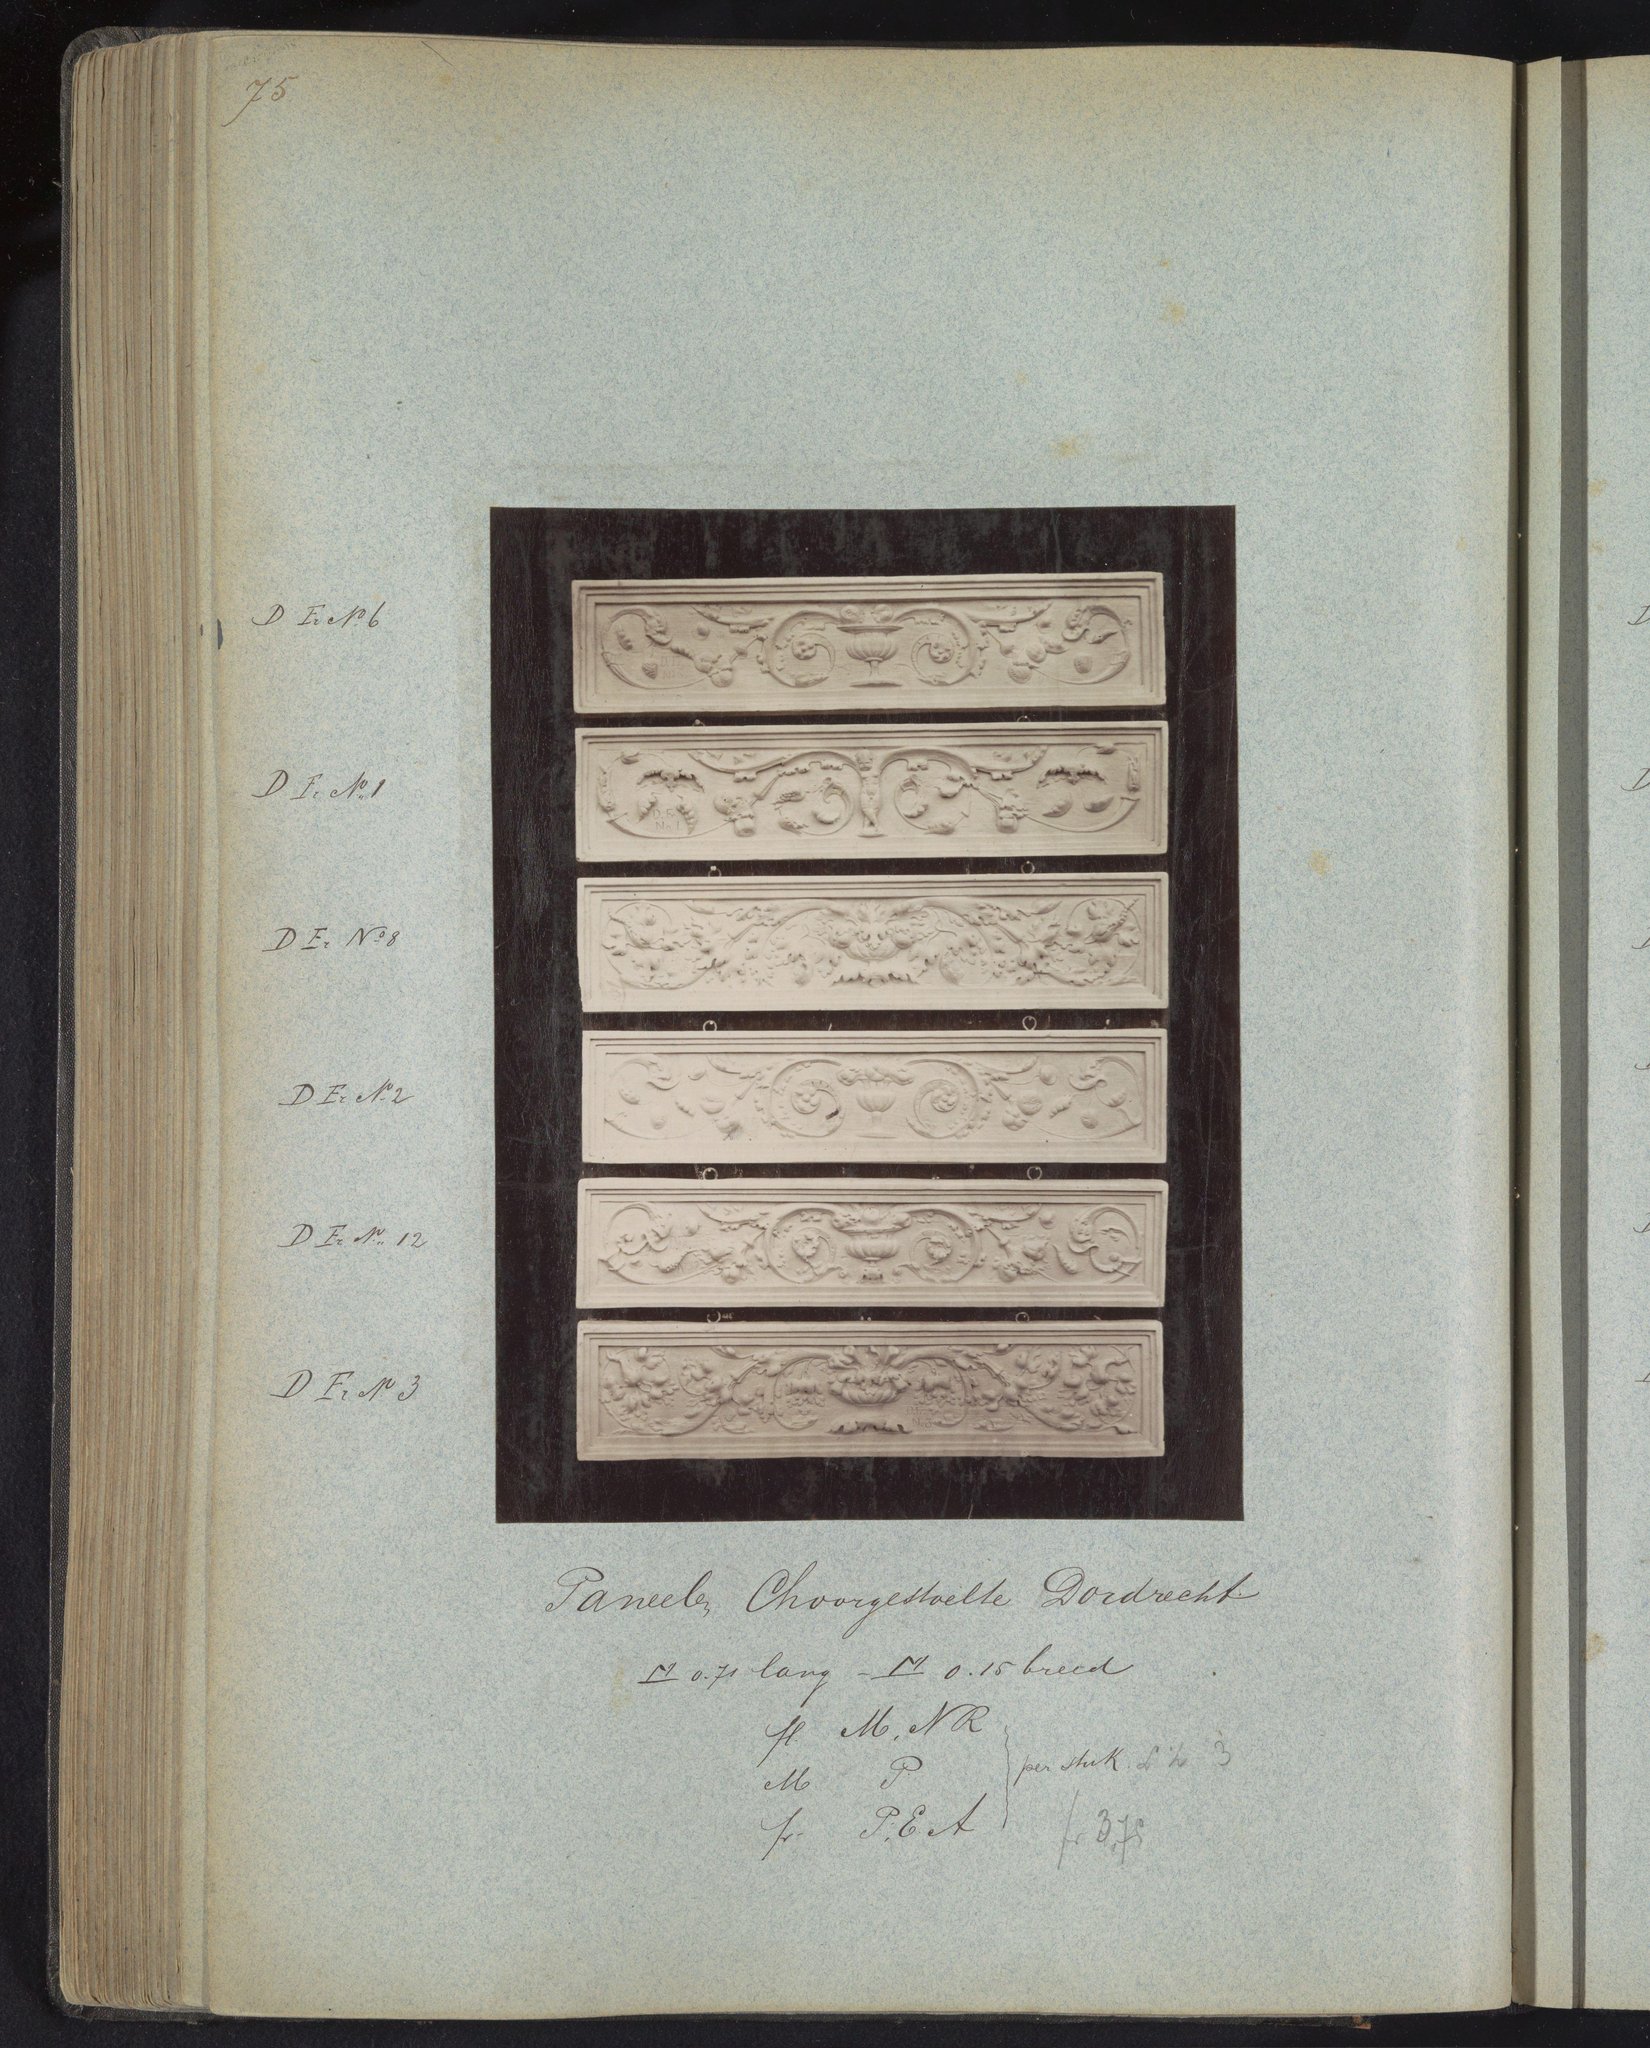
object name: album leaf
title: Zes gipsen afgietsels van panelen van een koorgestoelte, vermoedelijk van de Grote Kerk te Dordrecht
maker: Anonymous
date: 1875-1900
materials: paper, photographic support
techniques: albumen print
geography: dordrecht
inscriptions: annotation, annotation